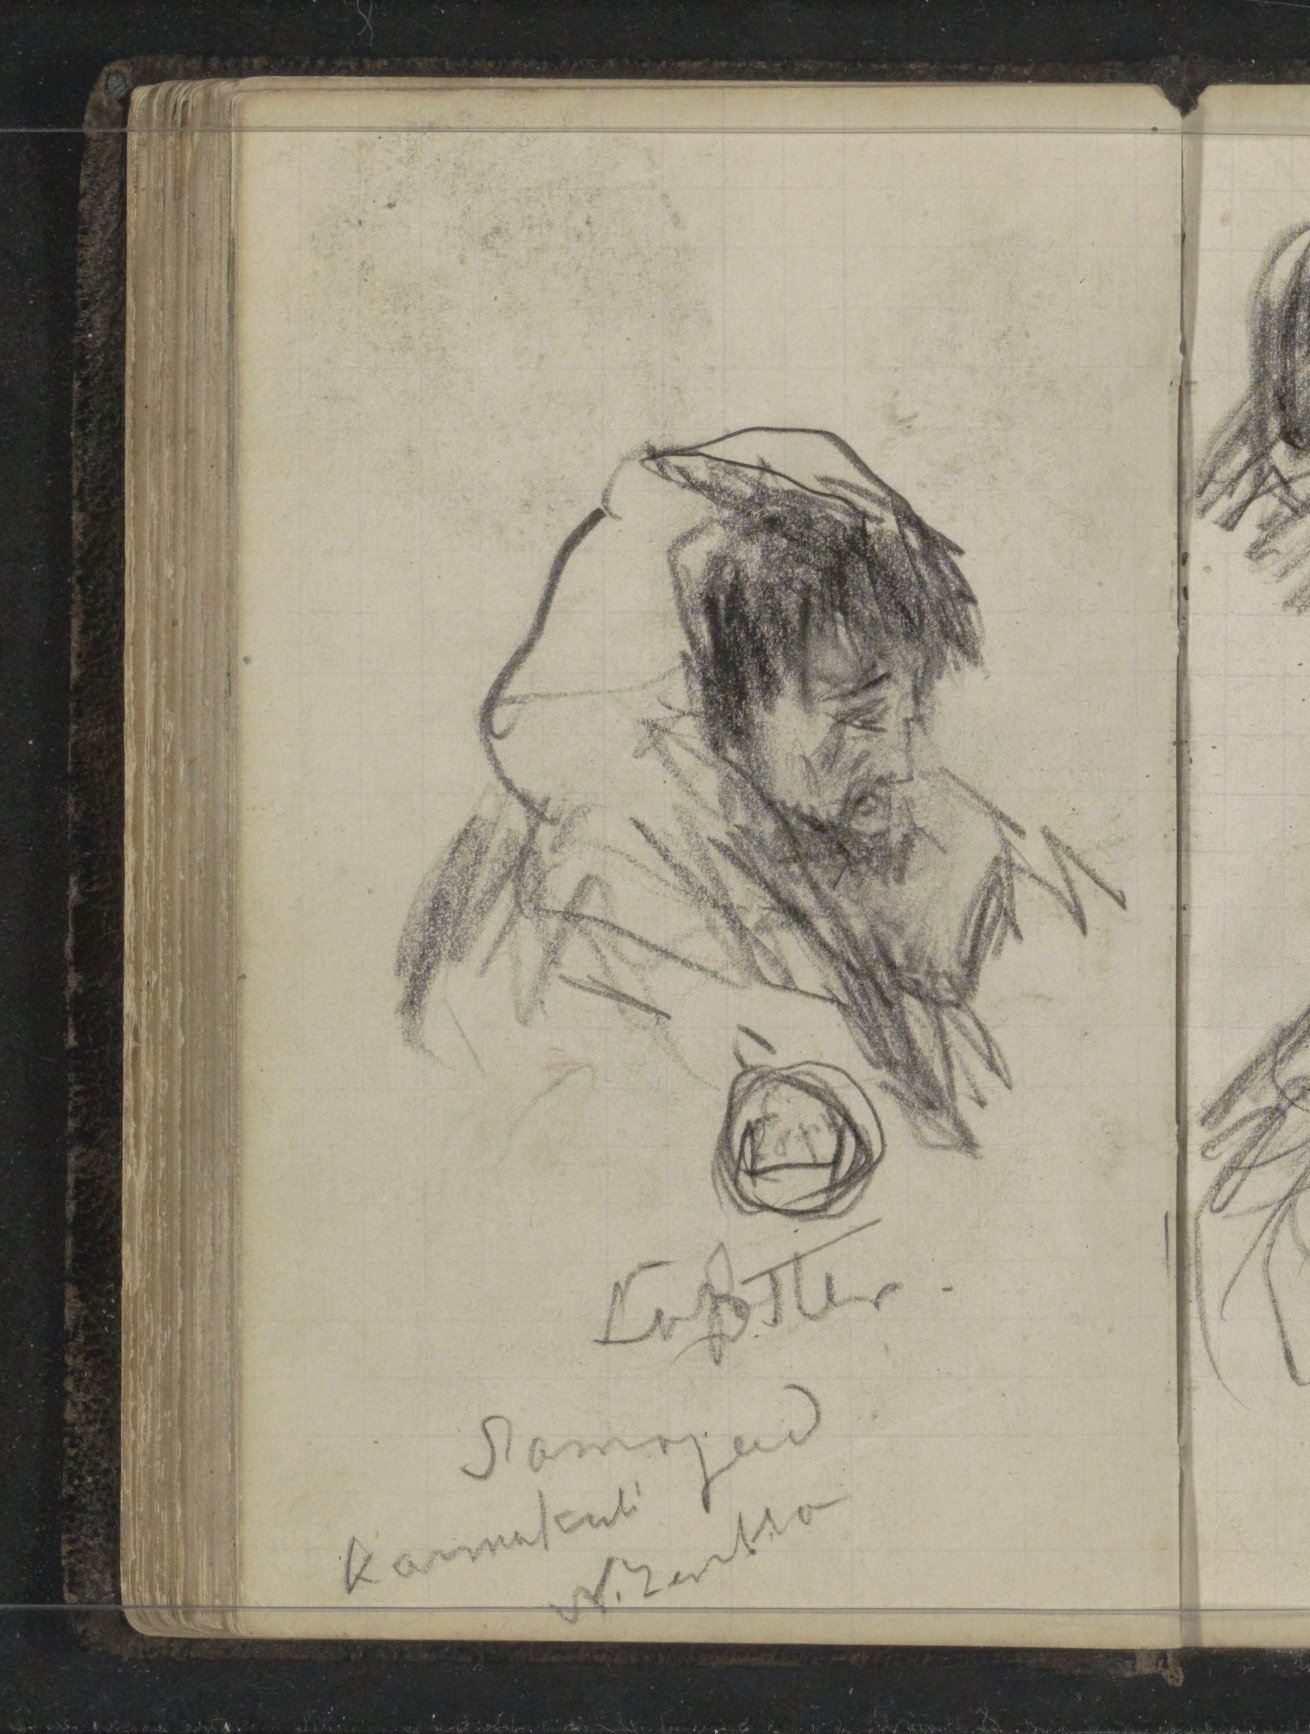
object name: sketchbook leaf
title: Portret van een Samojeed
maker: louis apol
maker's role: draughtsman, painter, print maker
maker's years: 1850-1936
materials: chalk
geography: malye karmakuly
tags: adult man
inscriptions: annotation: ‘Lapster / Samojeed / Karmakuli / N. Zembla’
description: In profiel. Blad 58 verso uit een schetsboek met 110 bladen betekend tijdens de expeditie naar Nova Zembla in 1880.